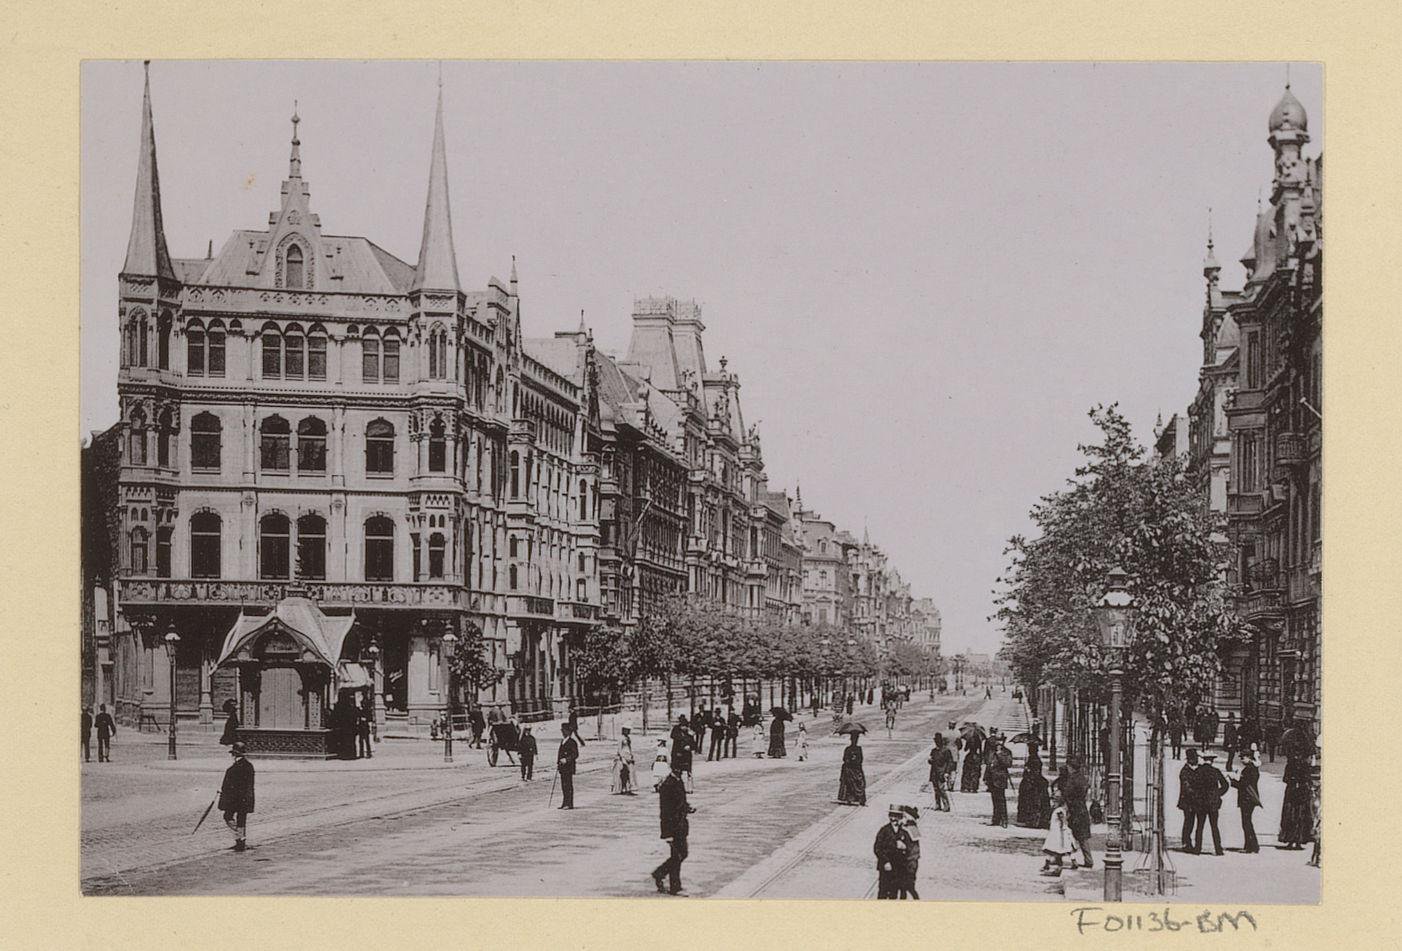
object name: photomechanical print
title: Hohenzollernring op de hoek met de Limburger Straße in Keulen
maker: Anonymous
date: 1880-1895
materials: paper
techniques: photograph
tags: street (+ city(-scape) with figures, staffage), cologne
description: Onderdeel van Fotoalbum met opnames van bezienswaardigheden in België, Duitsland en Noorwegen.